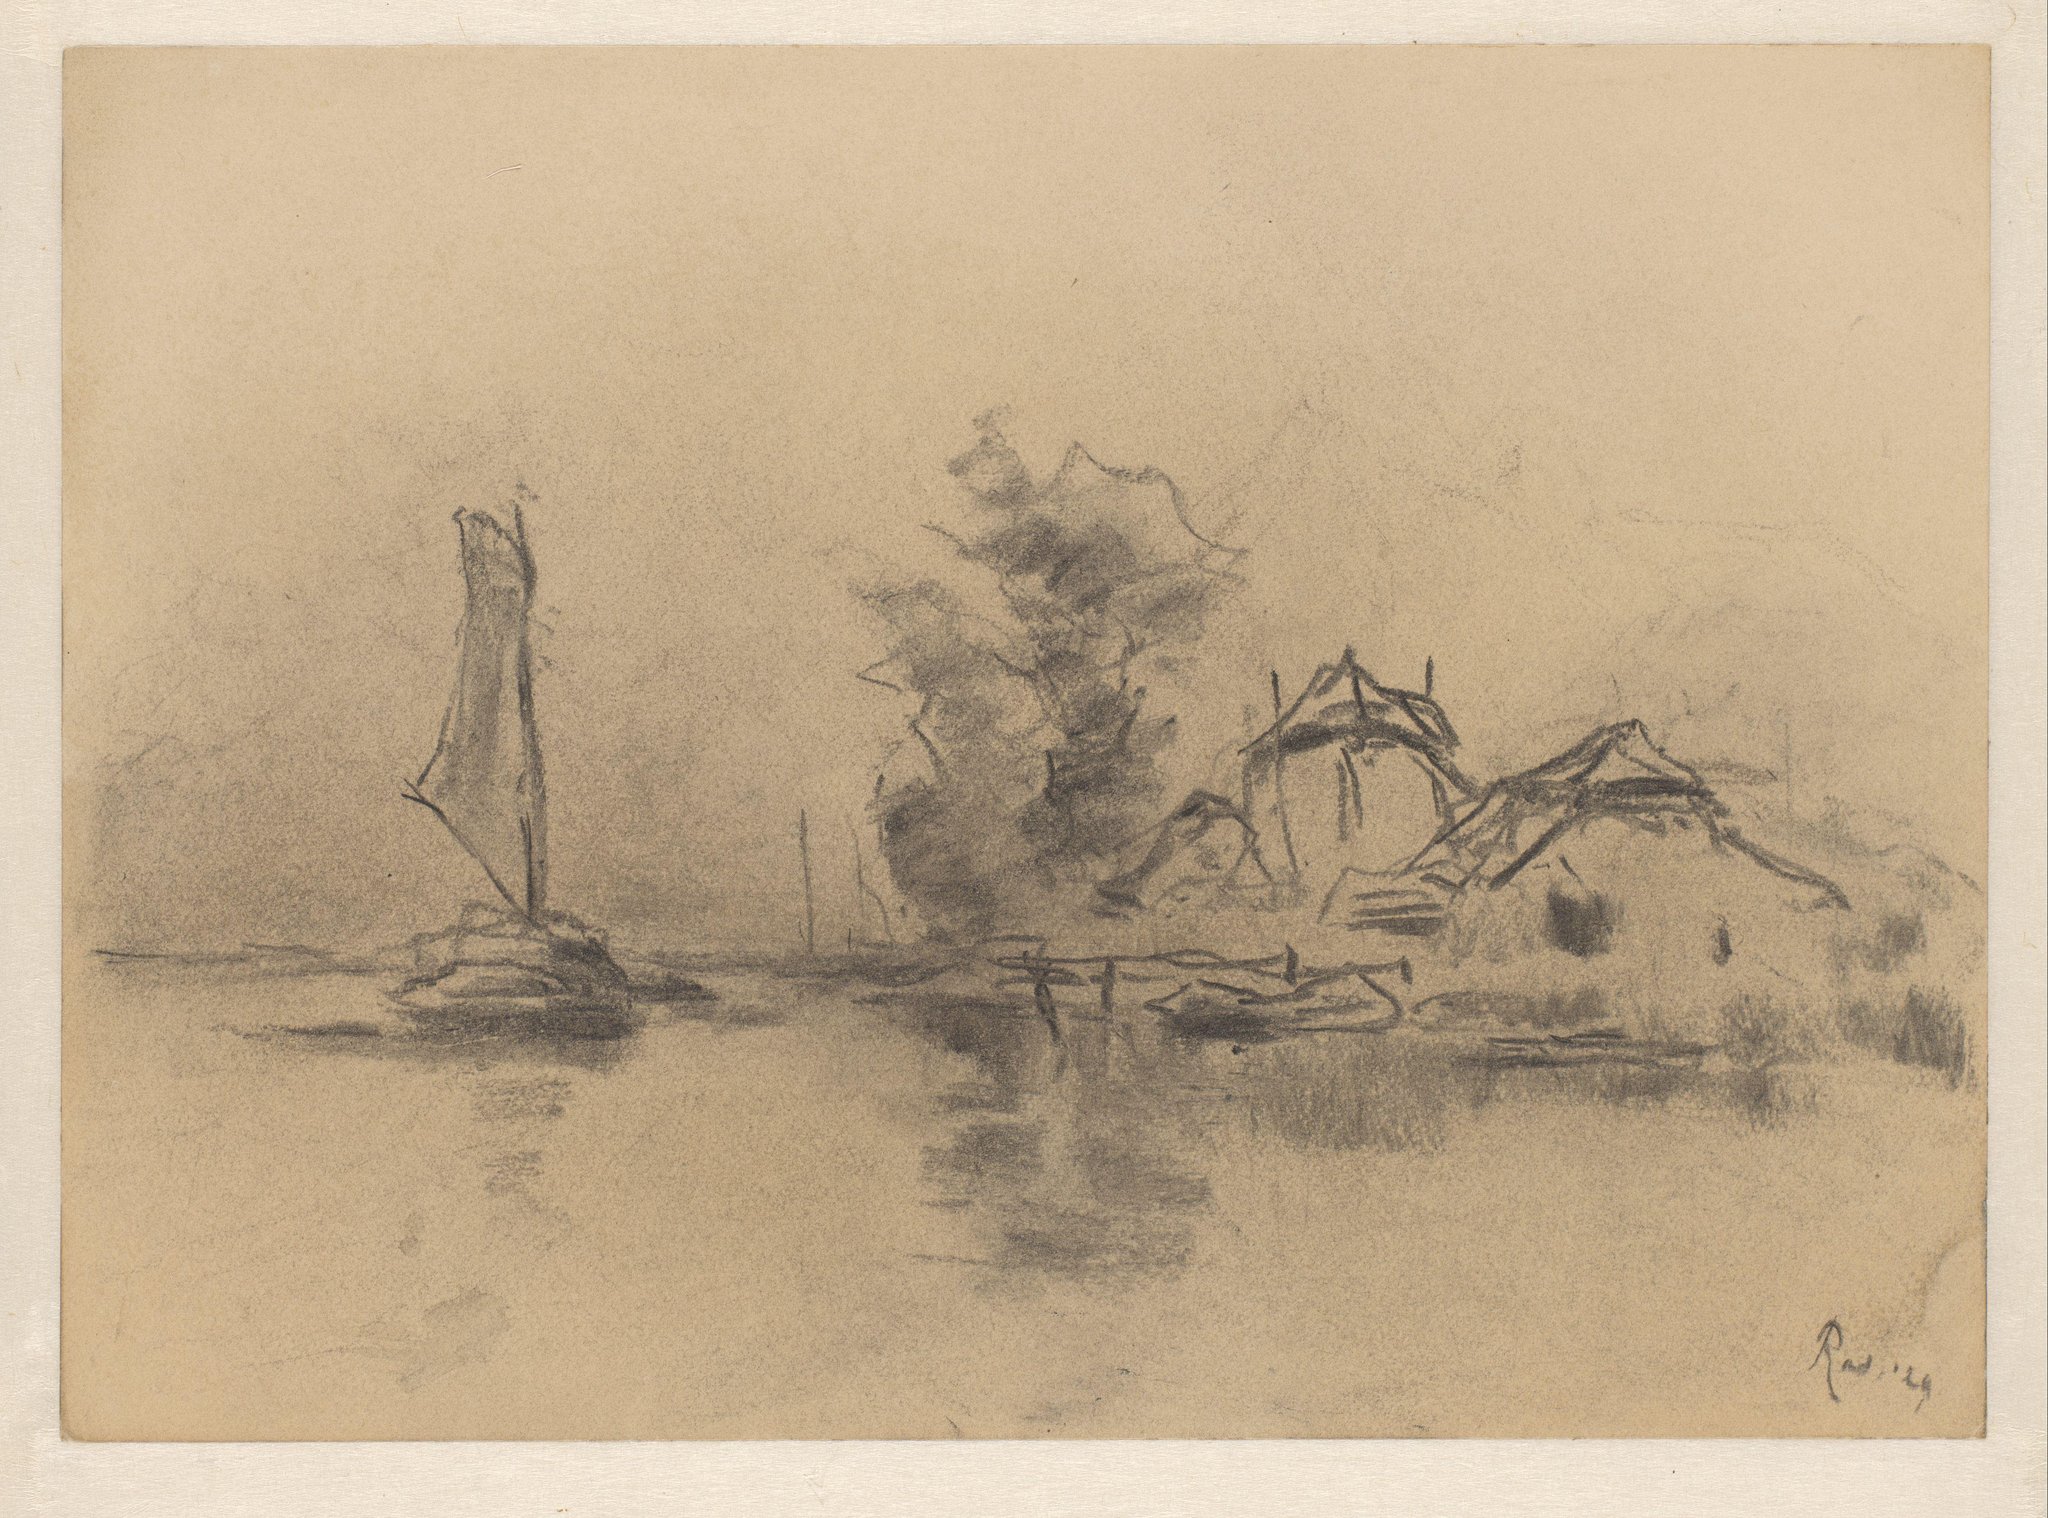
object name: drawing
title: Zeilend schip, boerderij en hooischelf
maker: pieter h.j.j. ras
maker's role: draughtsman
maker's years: 1857-1941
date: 1929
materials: chalk, paper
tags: farm or solitary house in landscape